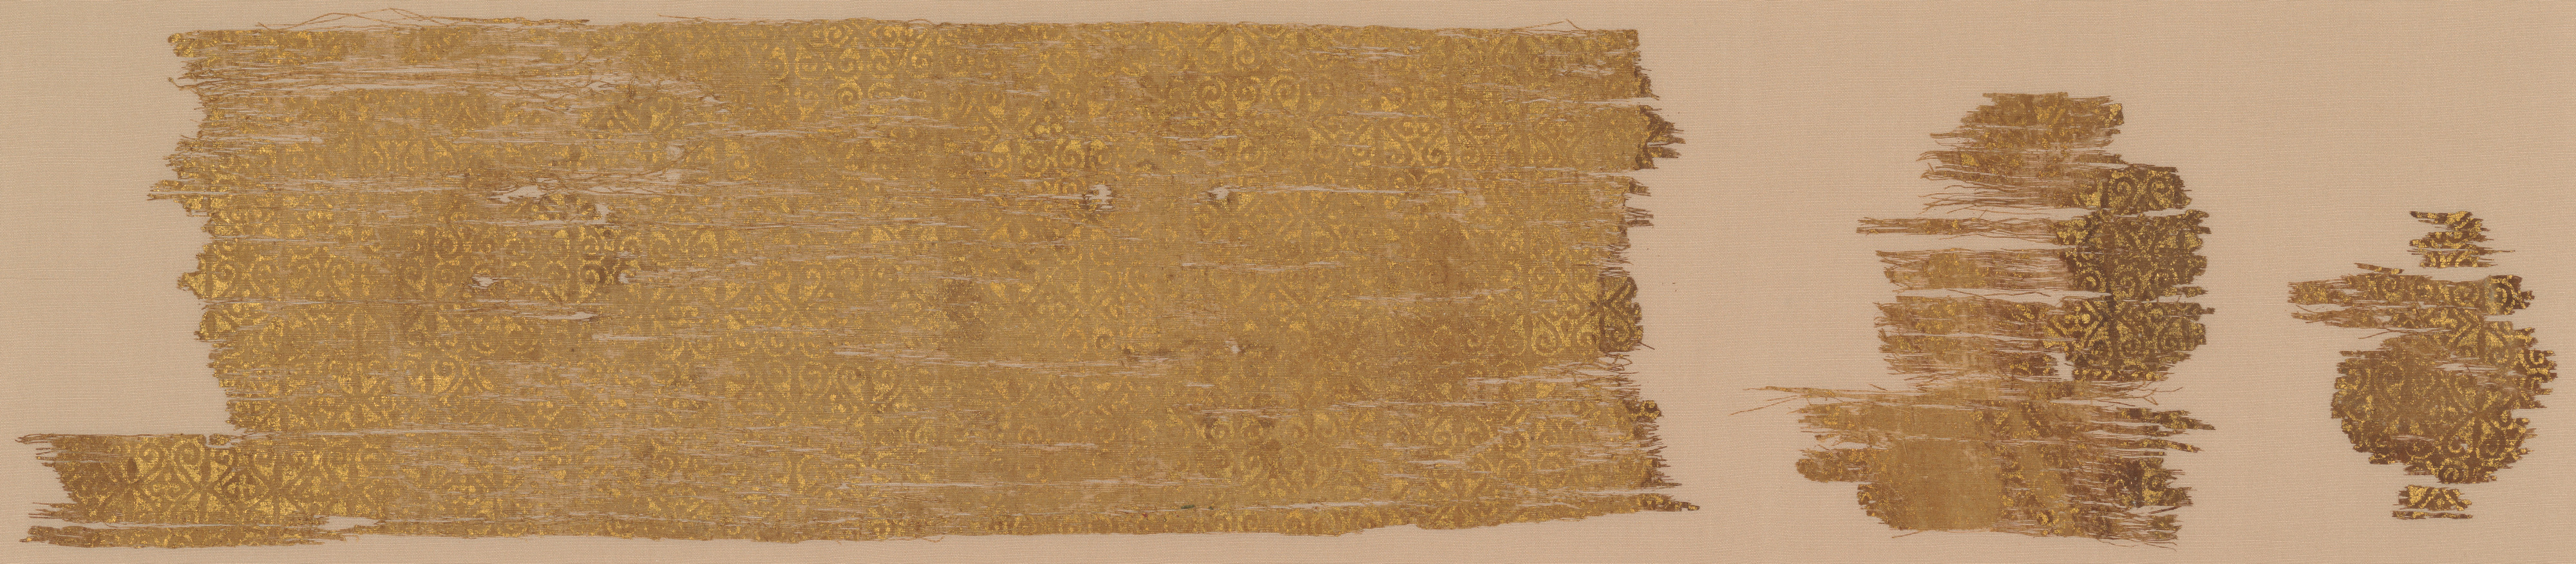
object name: textile fragment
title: Textile Printed in Gold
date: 917-923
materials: cotton, fur, linen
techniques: weave, printing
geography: iraq